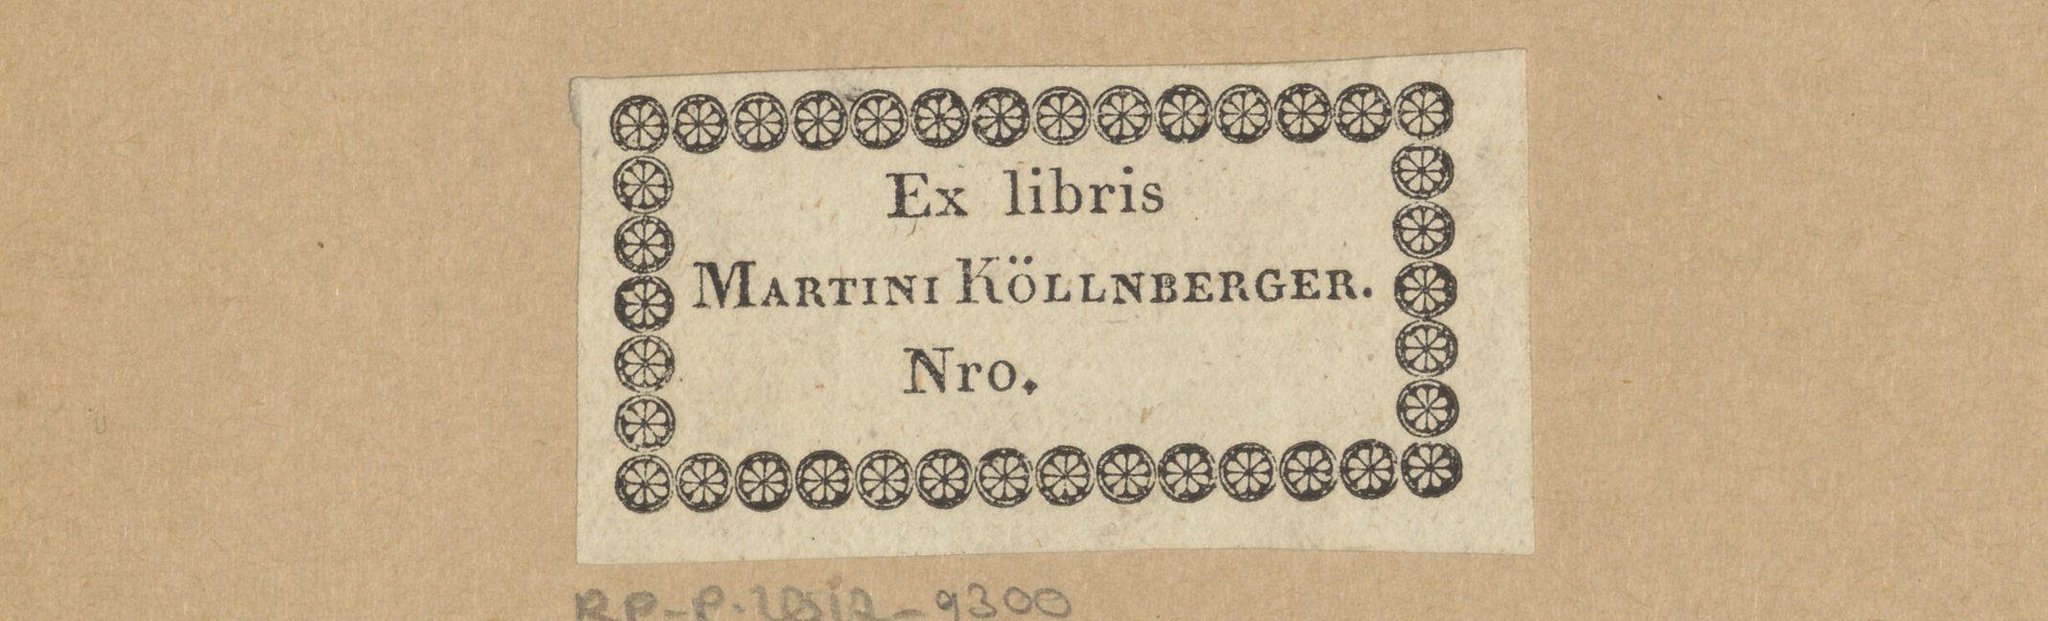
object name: bookplate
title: Ex libris van Martinus Köllnberger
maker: Anonymous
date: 1700-1899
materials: paper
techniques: letterpress printing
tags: martinus köllnberger